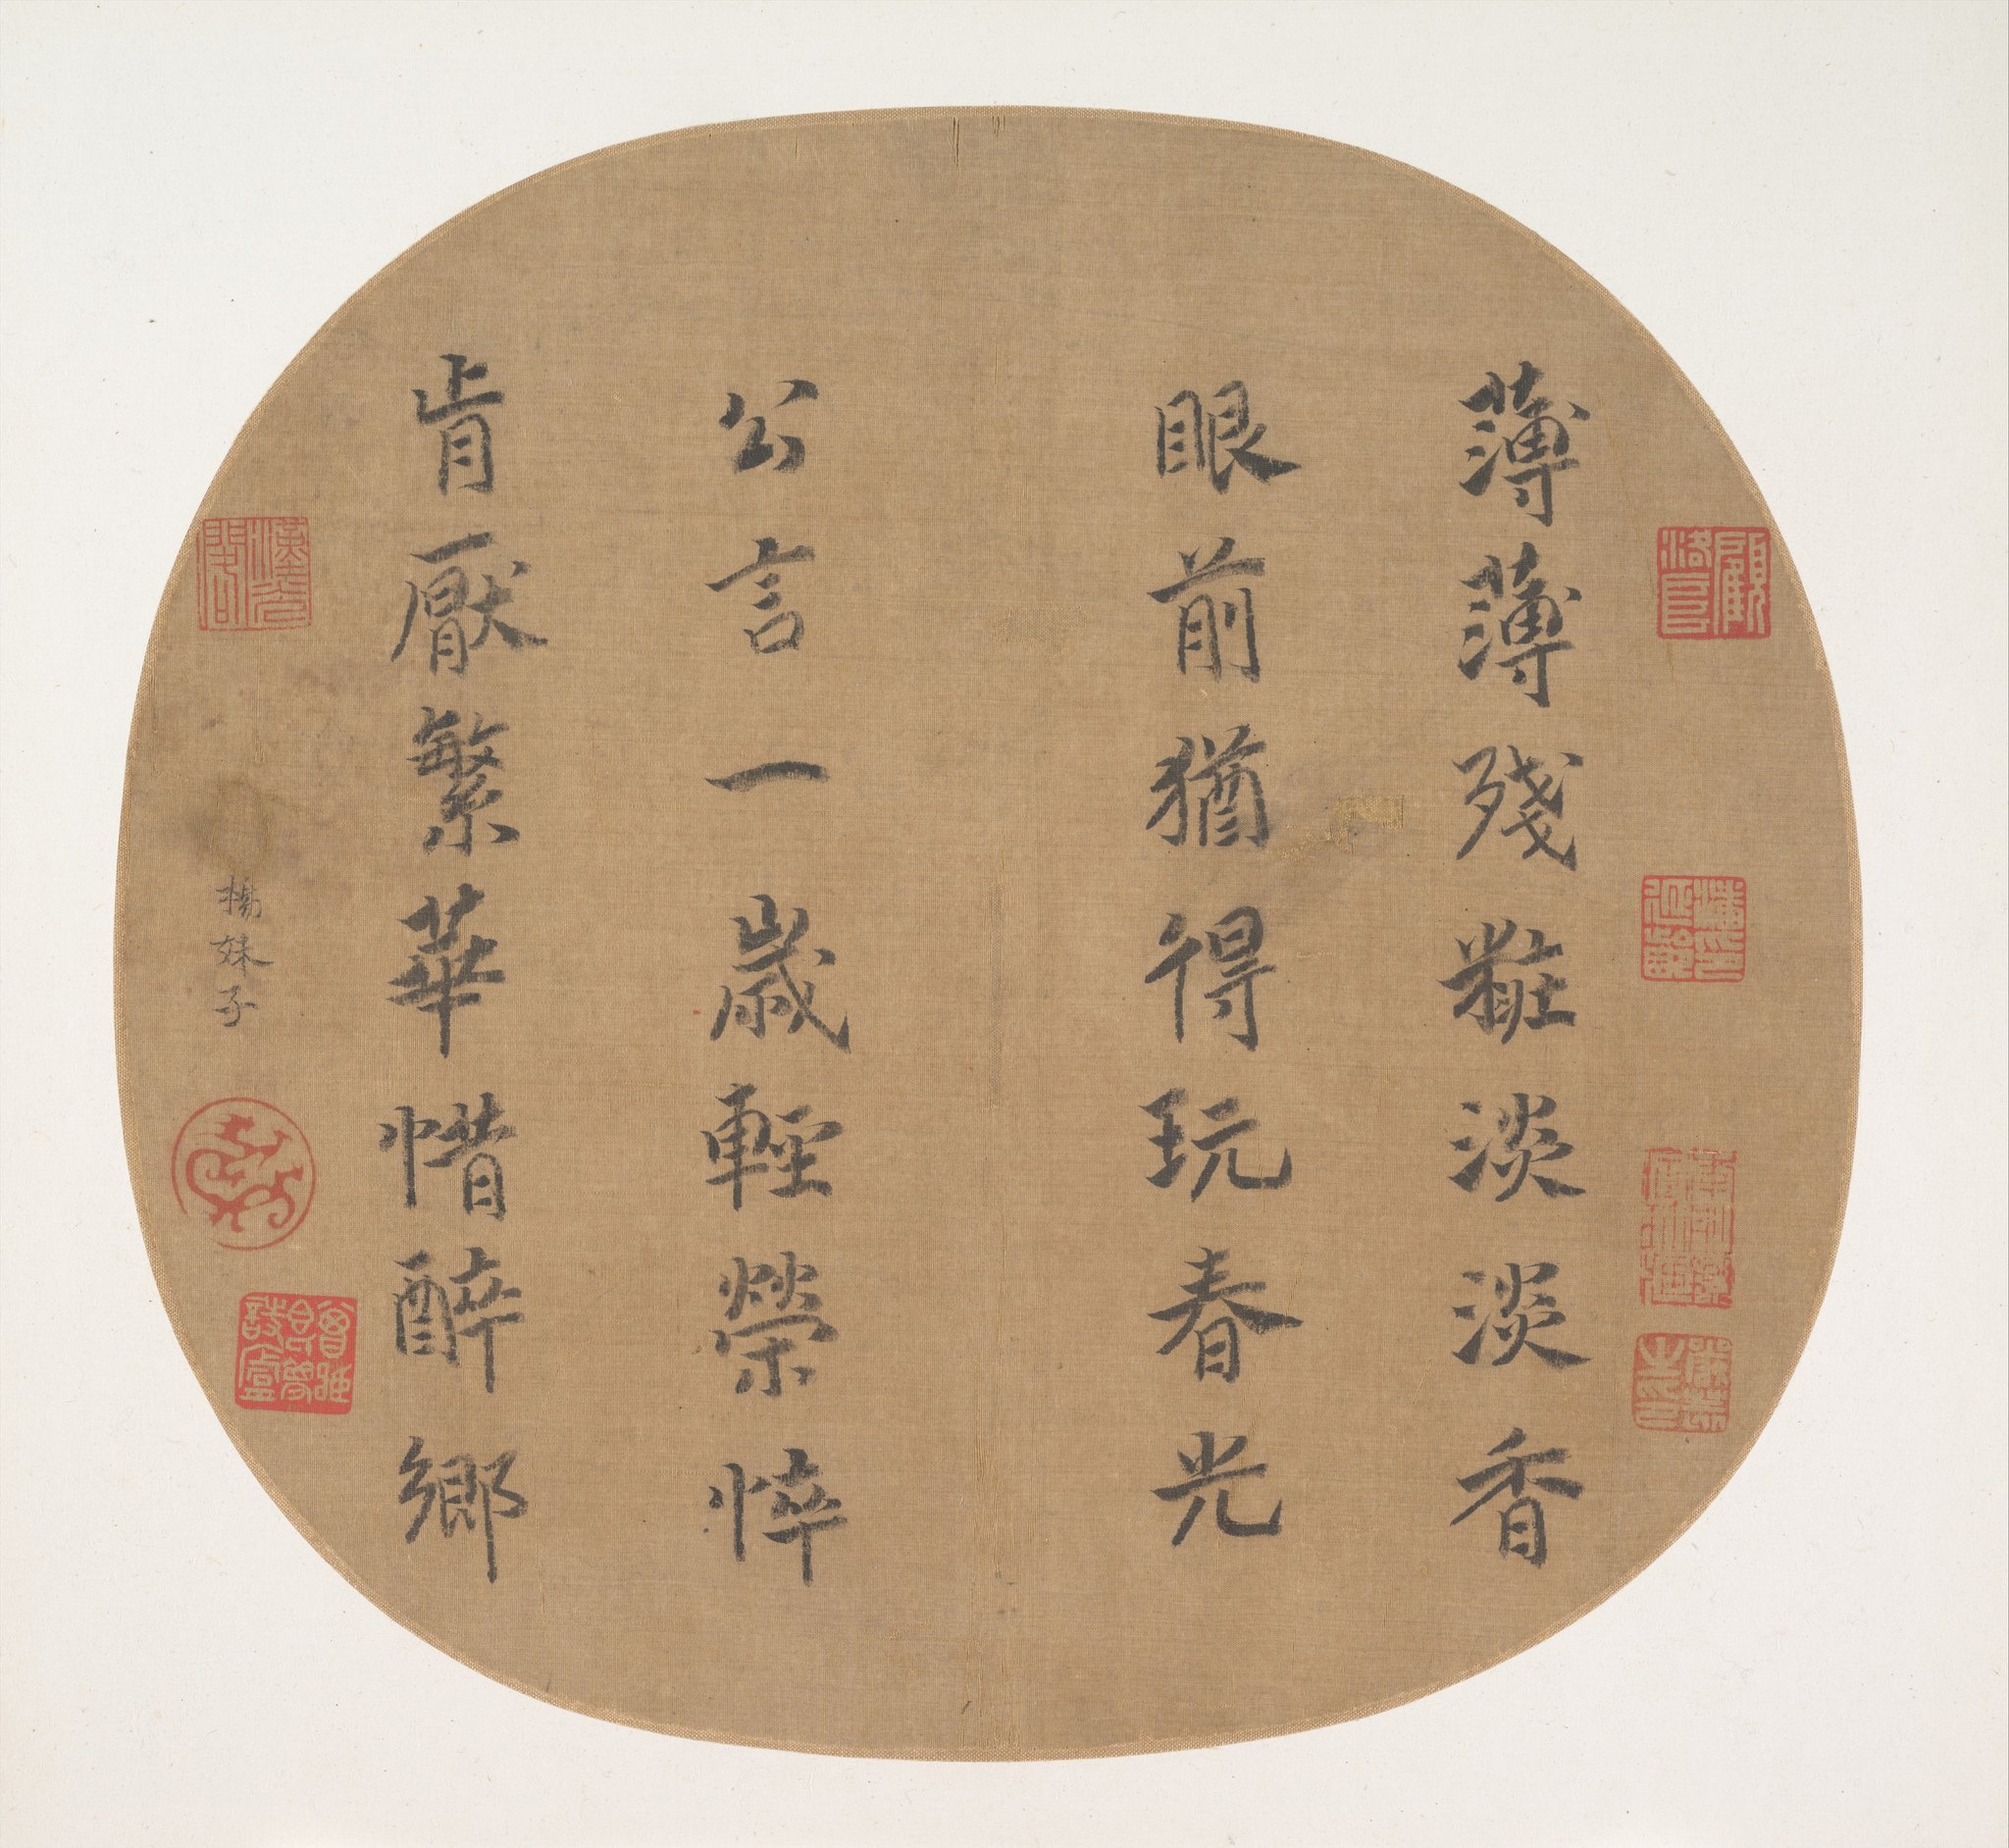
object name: fan mounted a an album leaf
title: Quatrain on spring’s radiance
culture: chinese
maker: empress yang meizi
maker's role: artist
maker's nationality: chinese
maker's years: 1162-1232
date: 1201-1233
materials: ink, silk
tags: poetry